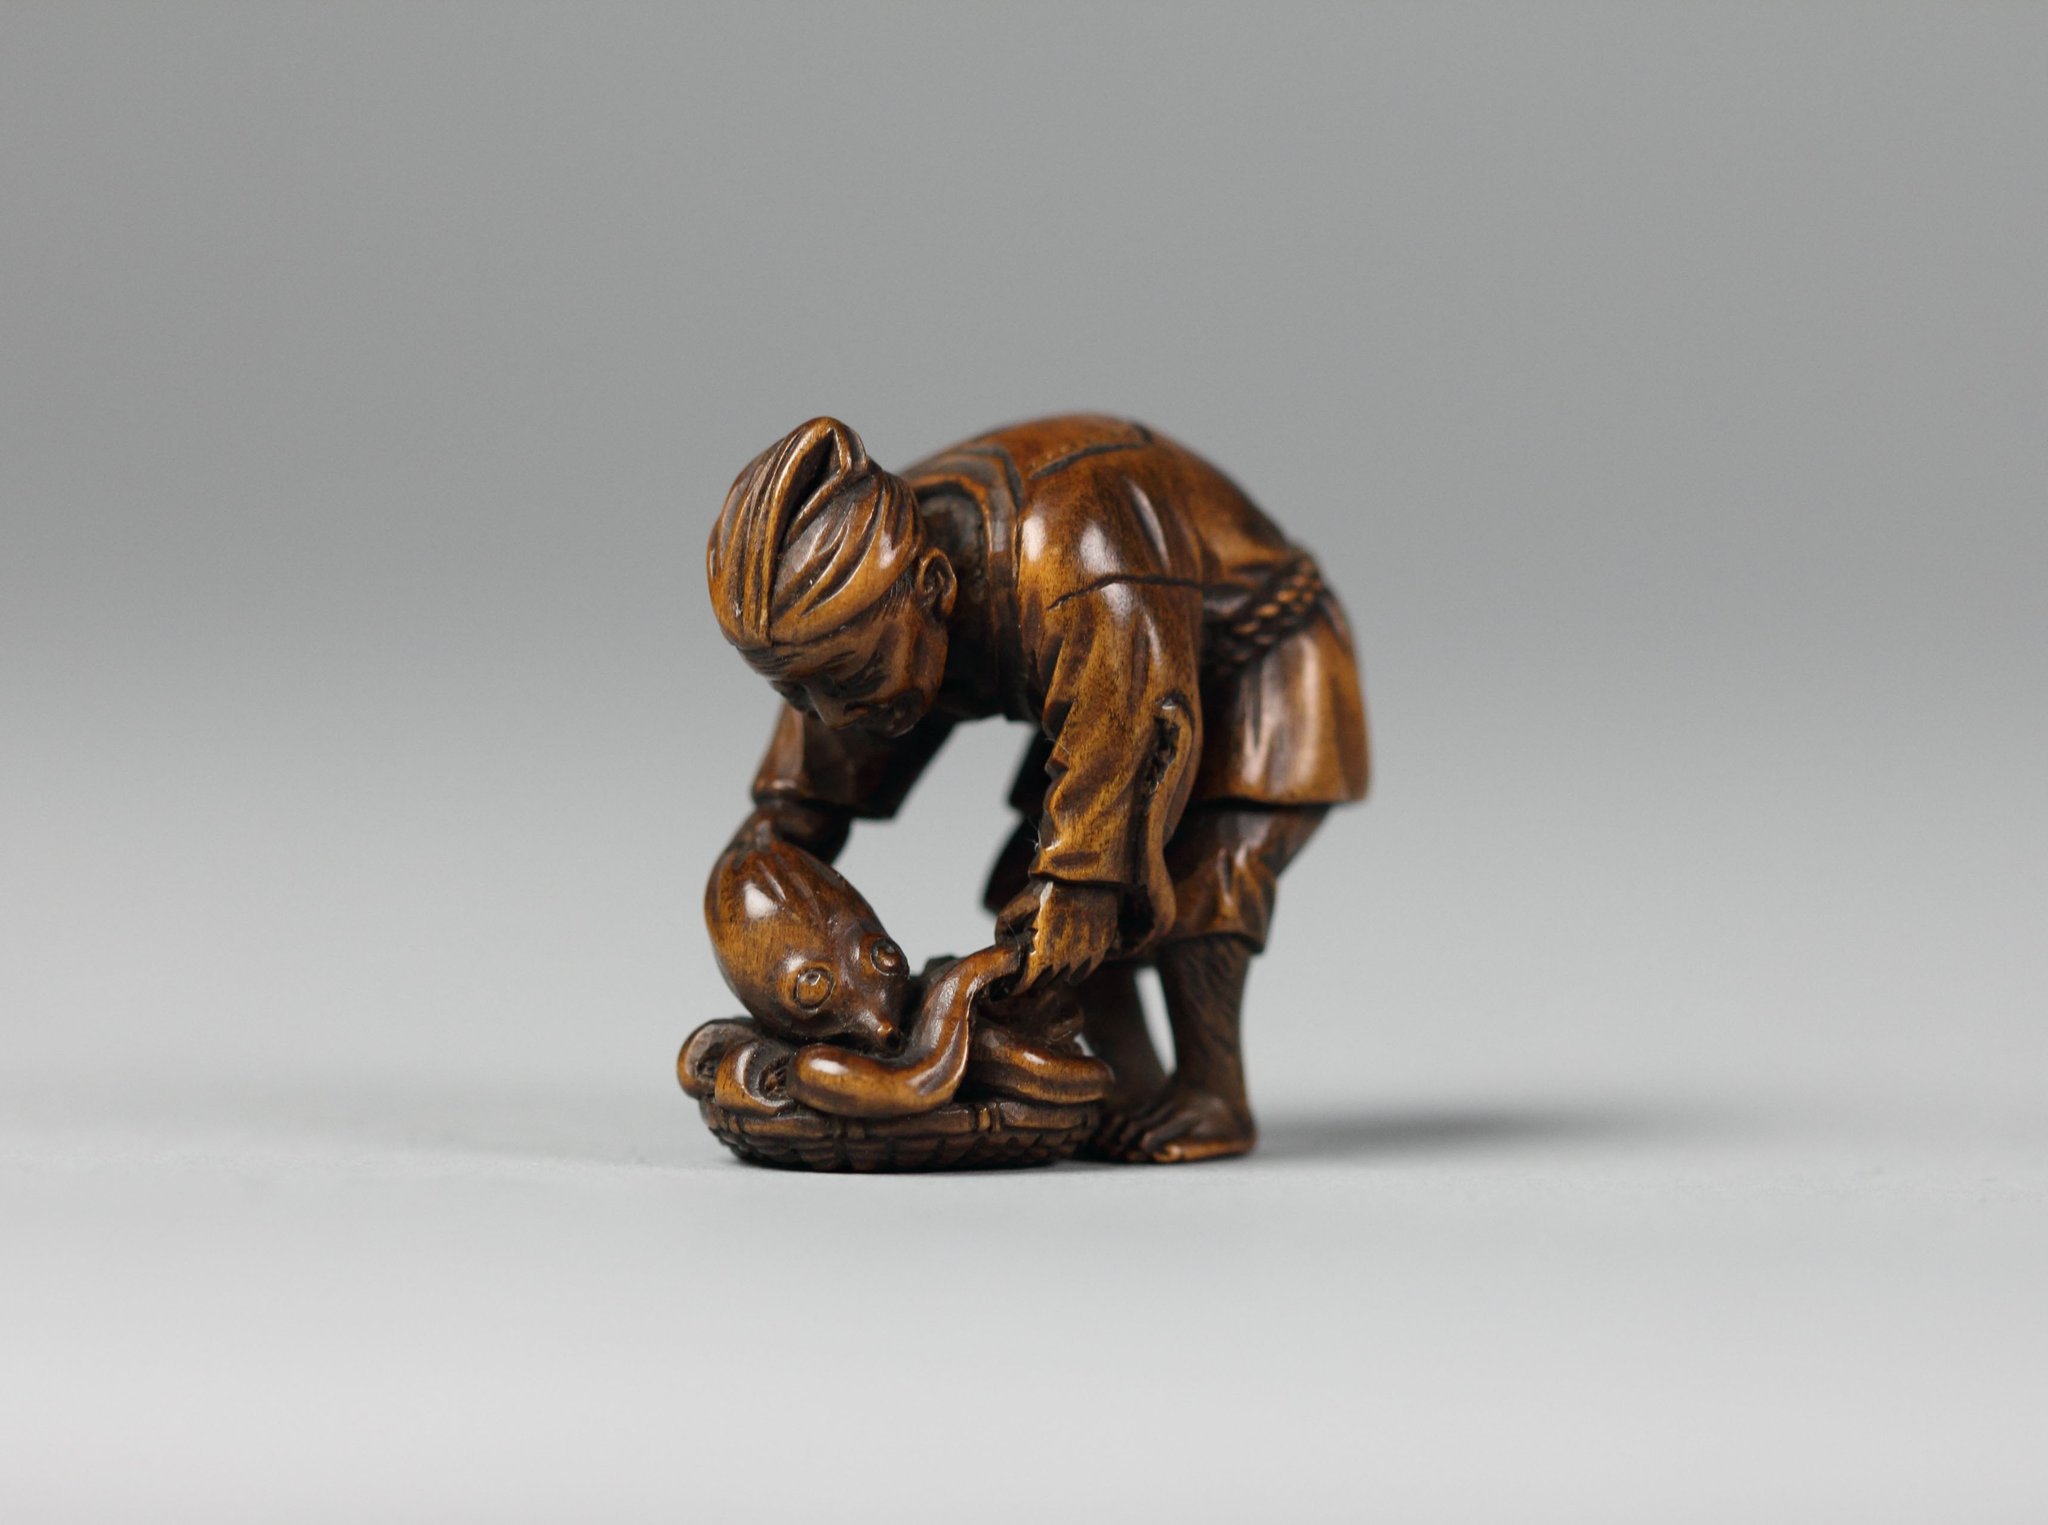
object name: netsuke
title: Netsuke of Snake Catcher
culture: japanese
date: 1801-1900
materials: wood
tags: men,snakes